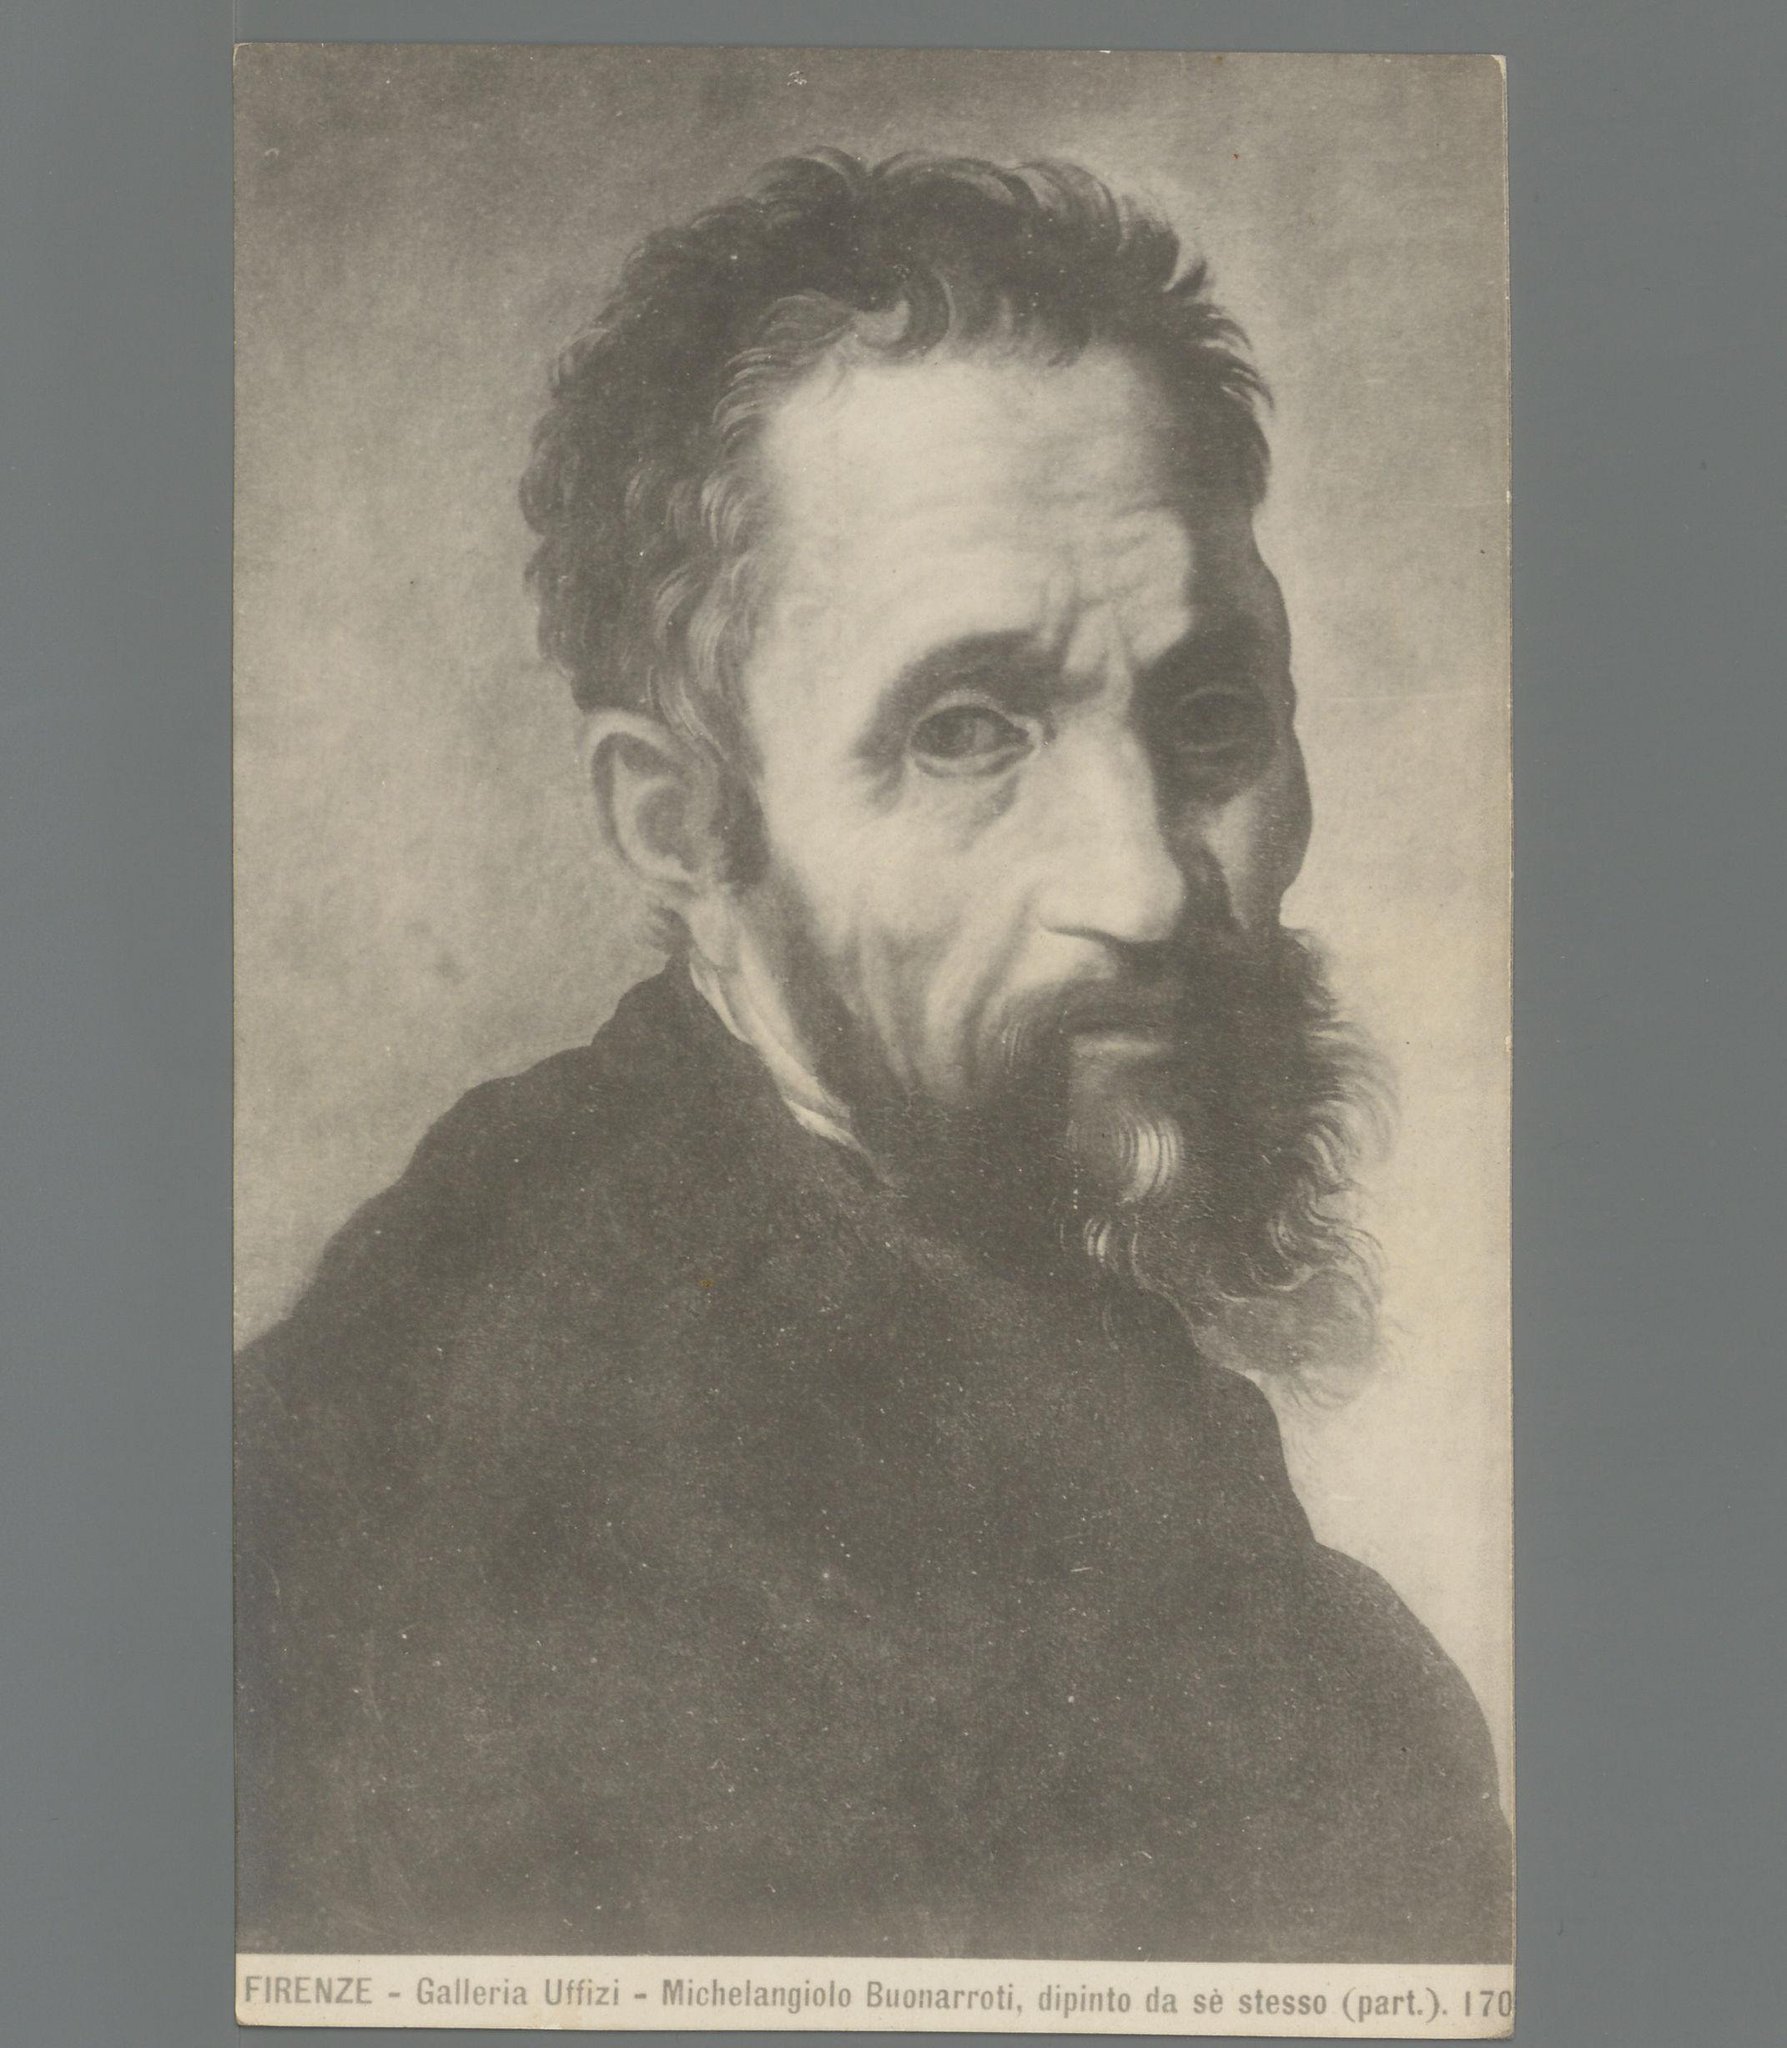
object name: photograph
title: Firenze. Galleria Uffizi. Michelangiolo Buonarroti, dipinto da sè stesso (part.)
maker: Anonymous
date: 1889-1906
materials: photographic support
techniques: photography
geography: florence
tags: rome, painter, draughtsman, sculptor, michelangelo, portrait, self-portrait of artist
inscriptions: inscription: ‘"Ubermoro"’, collector's mark: ‘AFE v S’